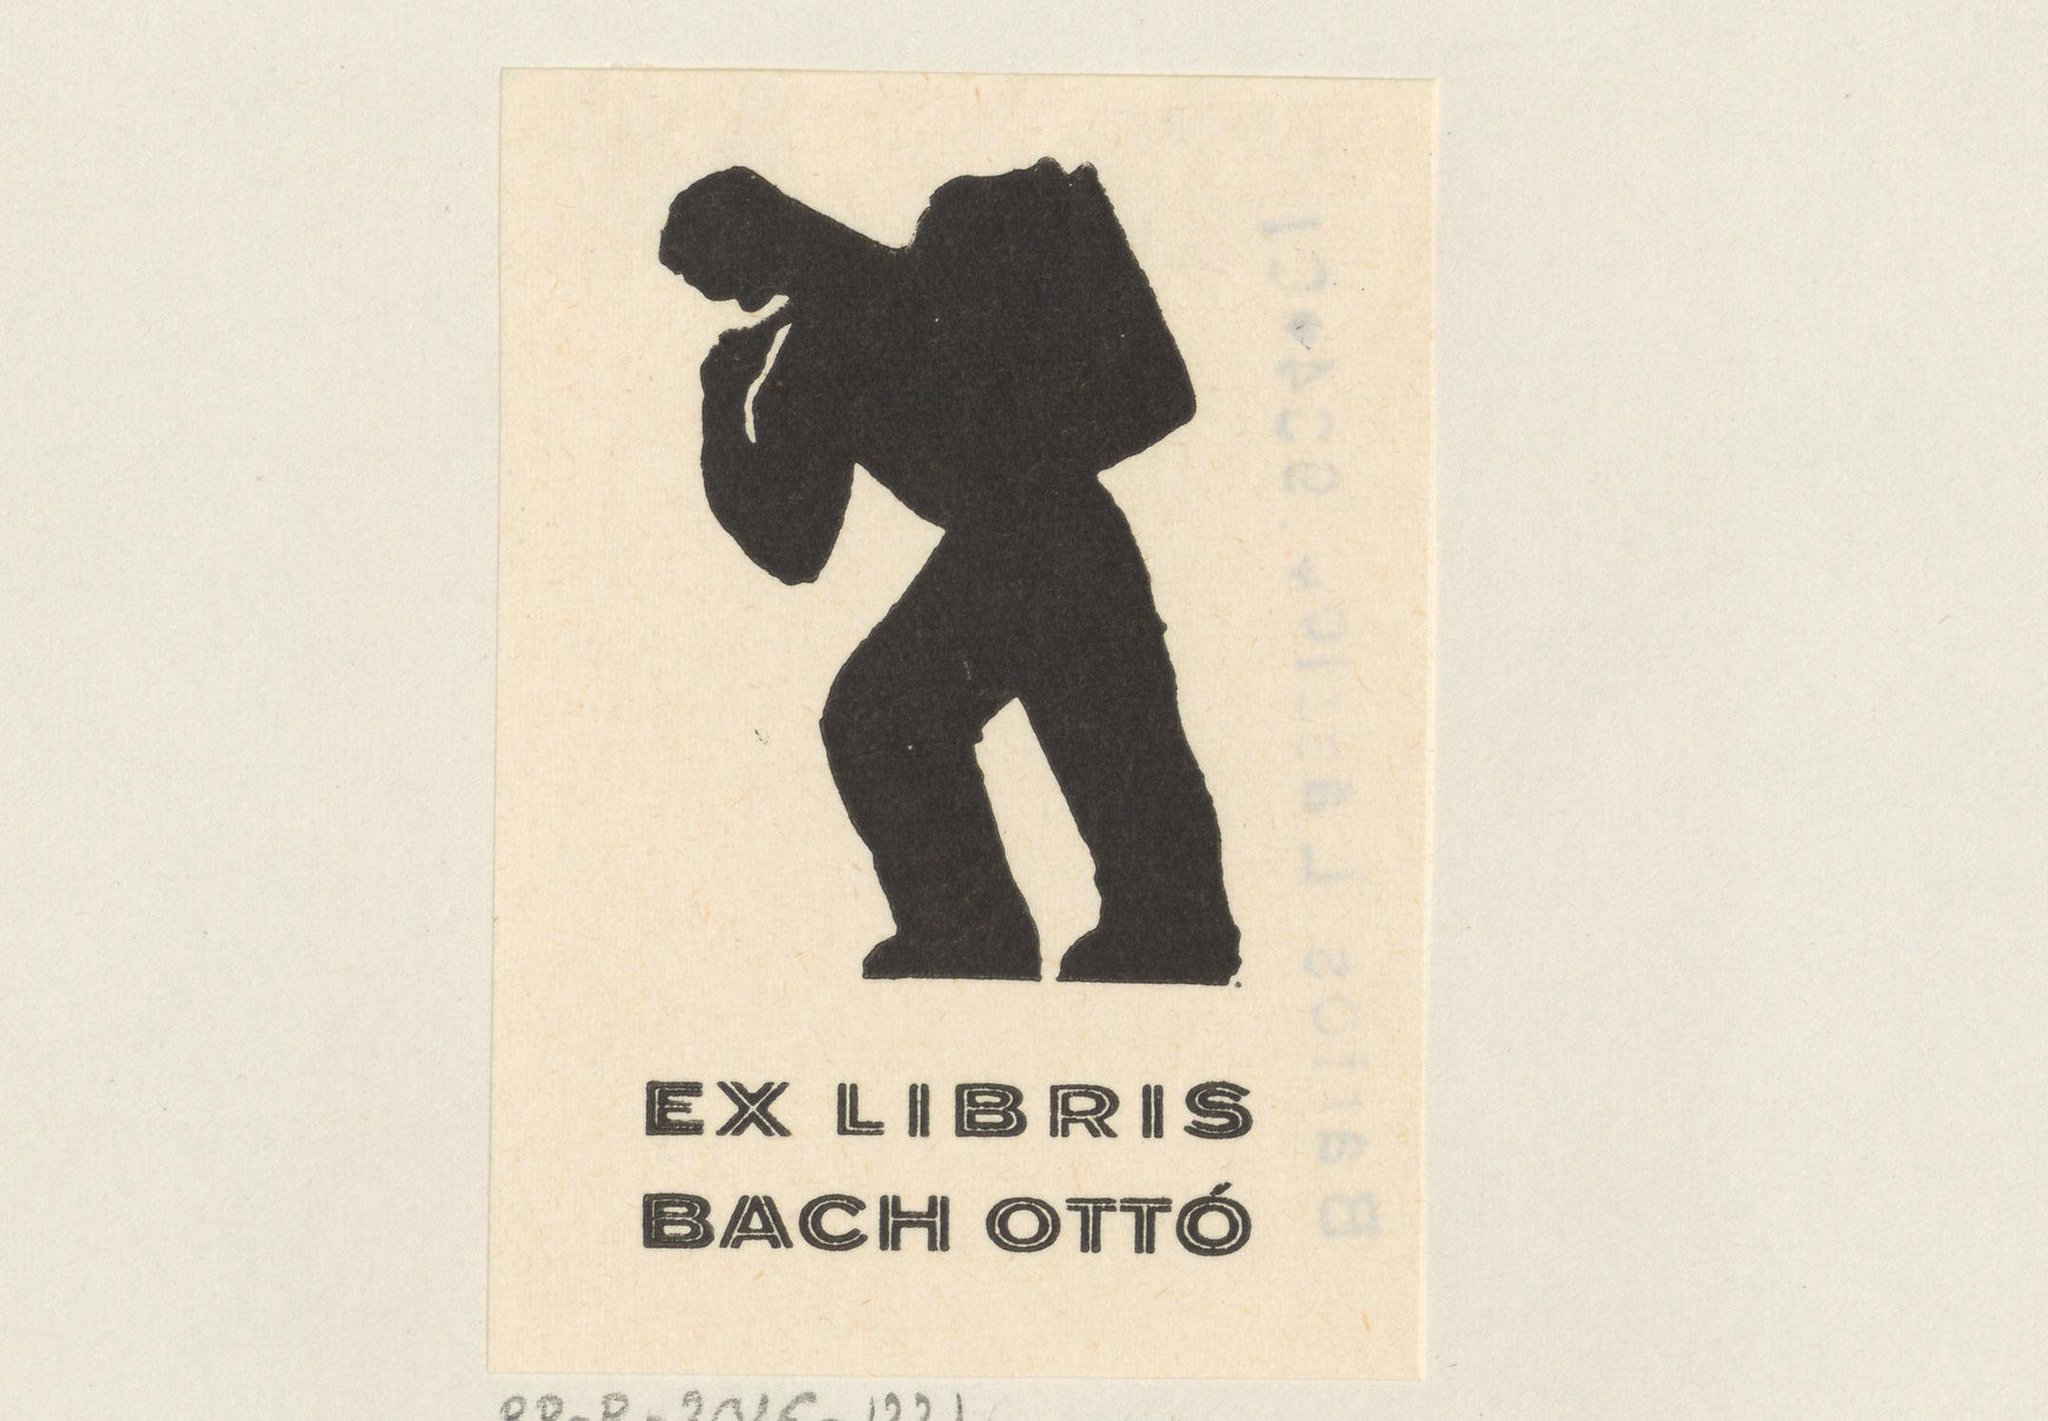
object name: bookplate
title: Ex libris van Bach Ottó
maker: lászló bartos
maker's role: print maker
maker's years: 1902-1943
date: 1934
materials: paper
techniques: printing block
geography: hungary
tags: miner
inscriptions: workshop stamp: ‘Bartos.Lászlo.1934.Cl’